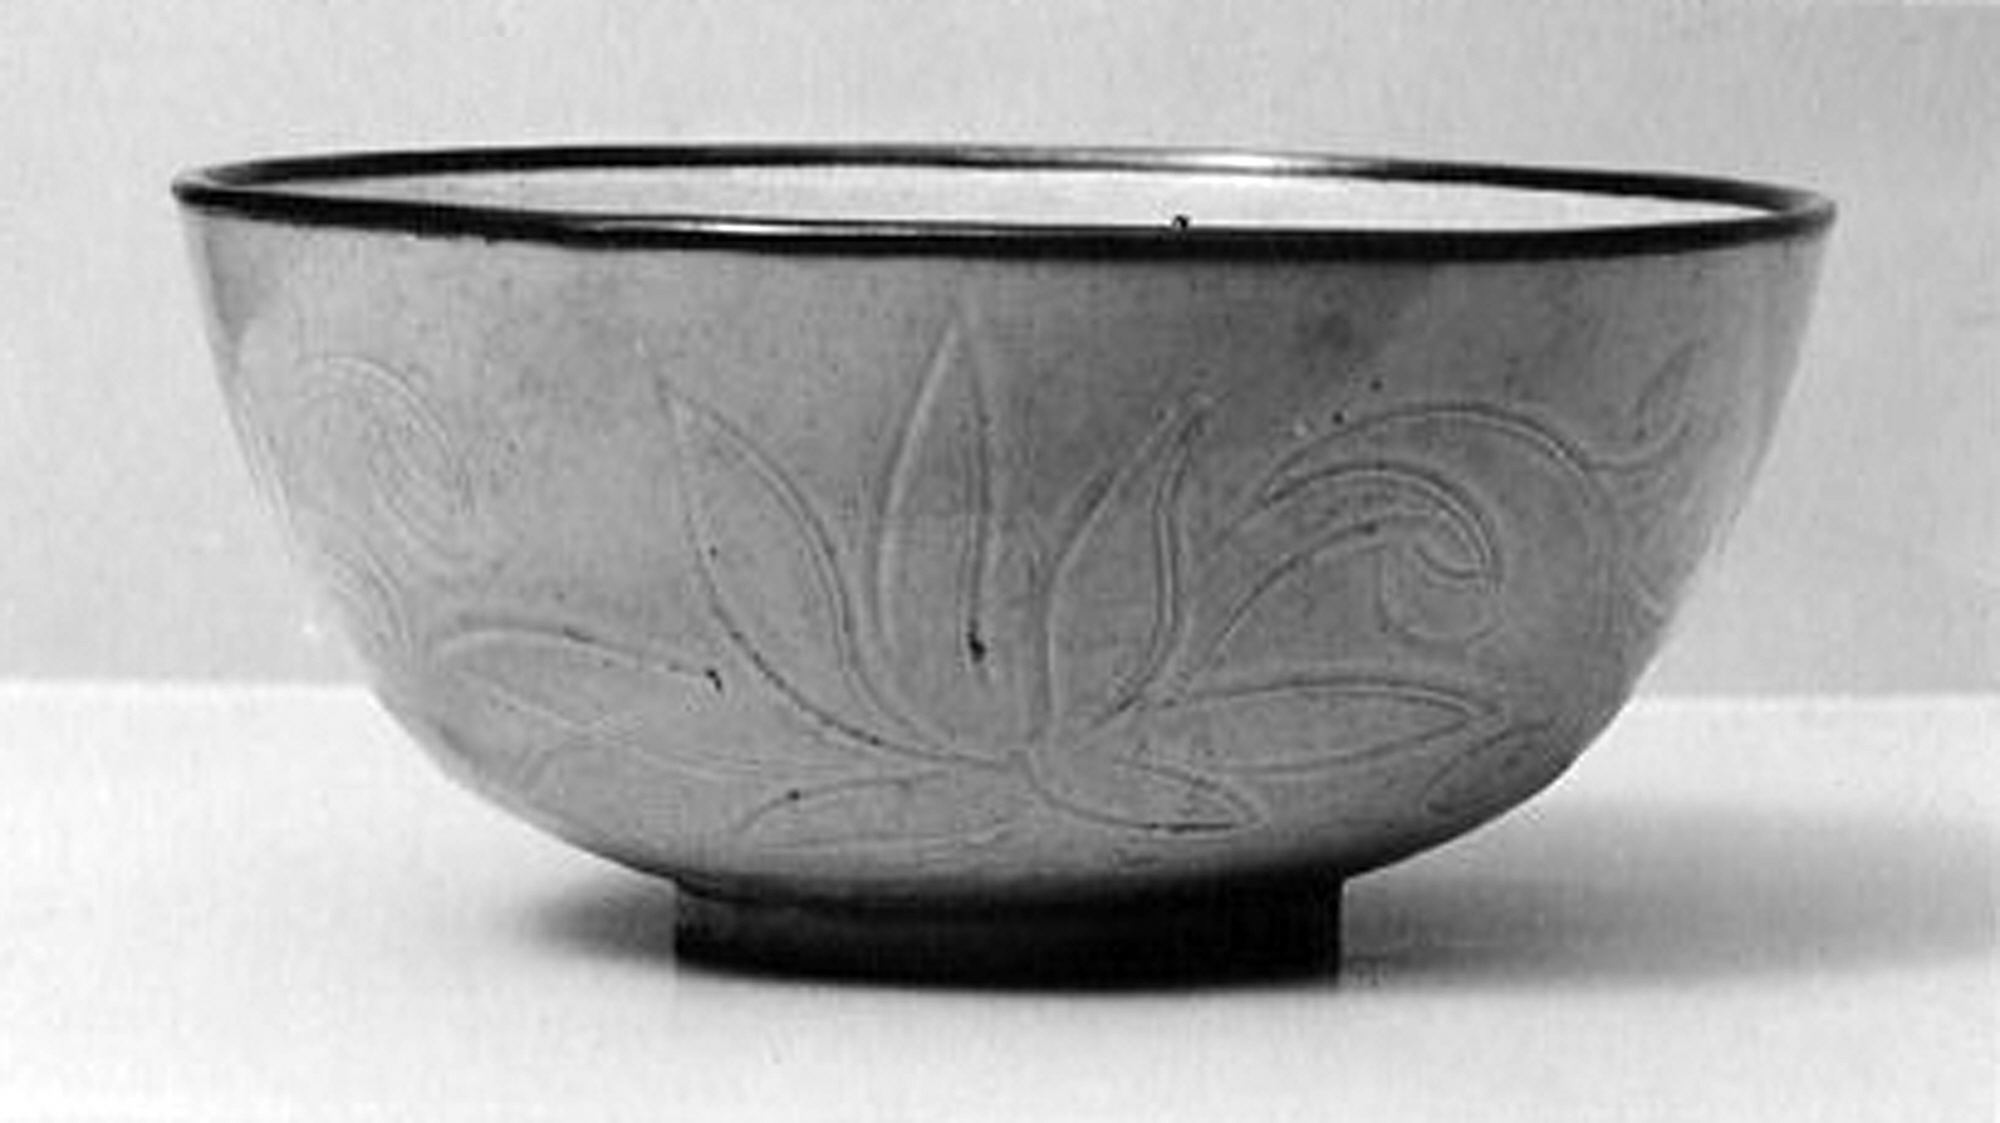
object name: bowl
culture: chinese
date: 960-1279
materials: pottery